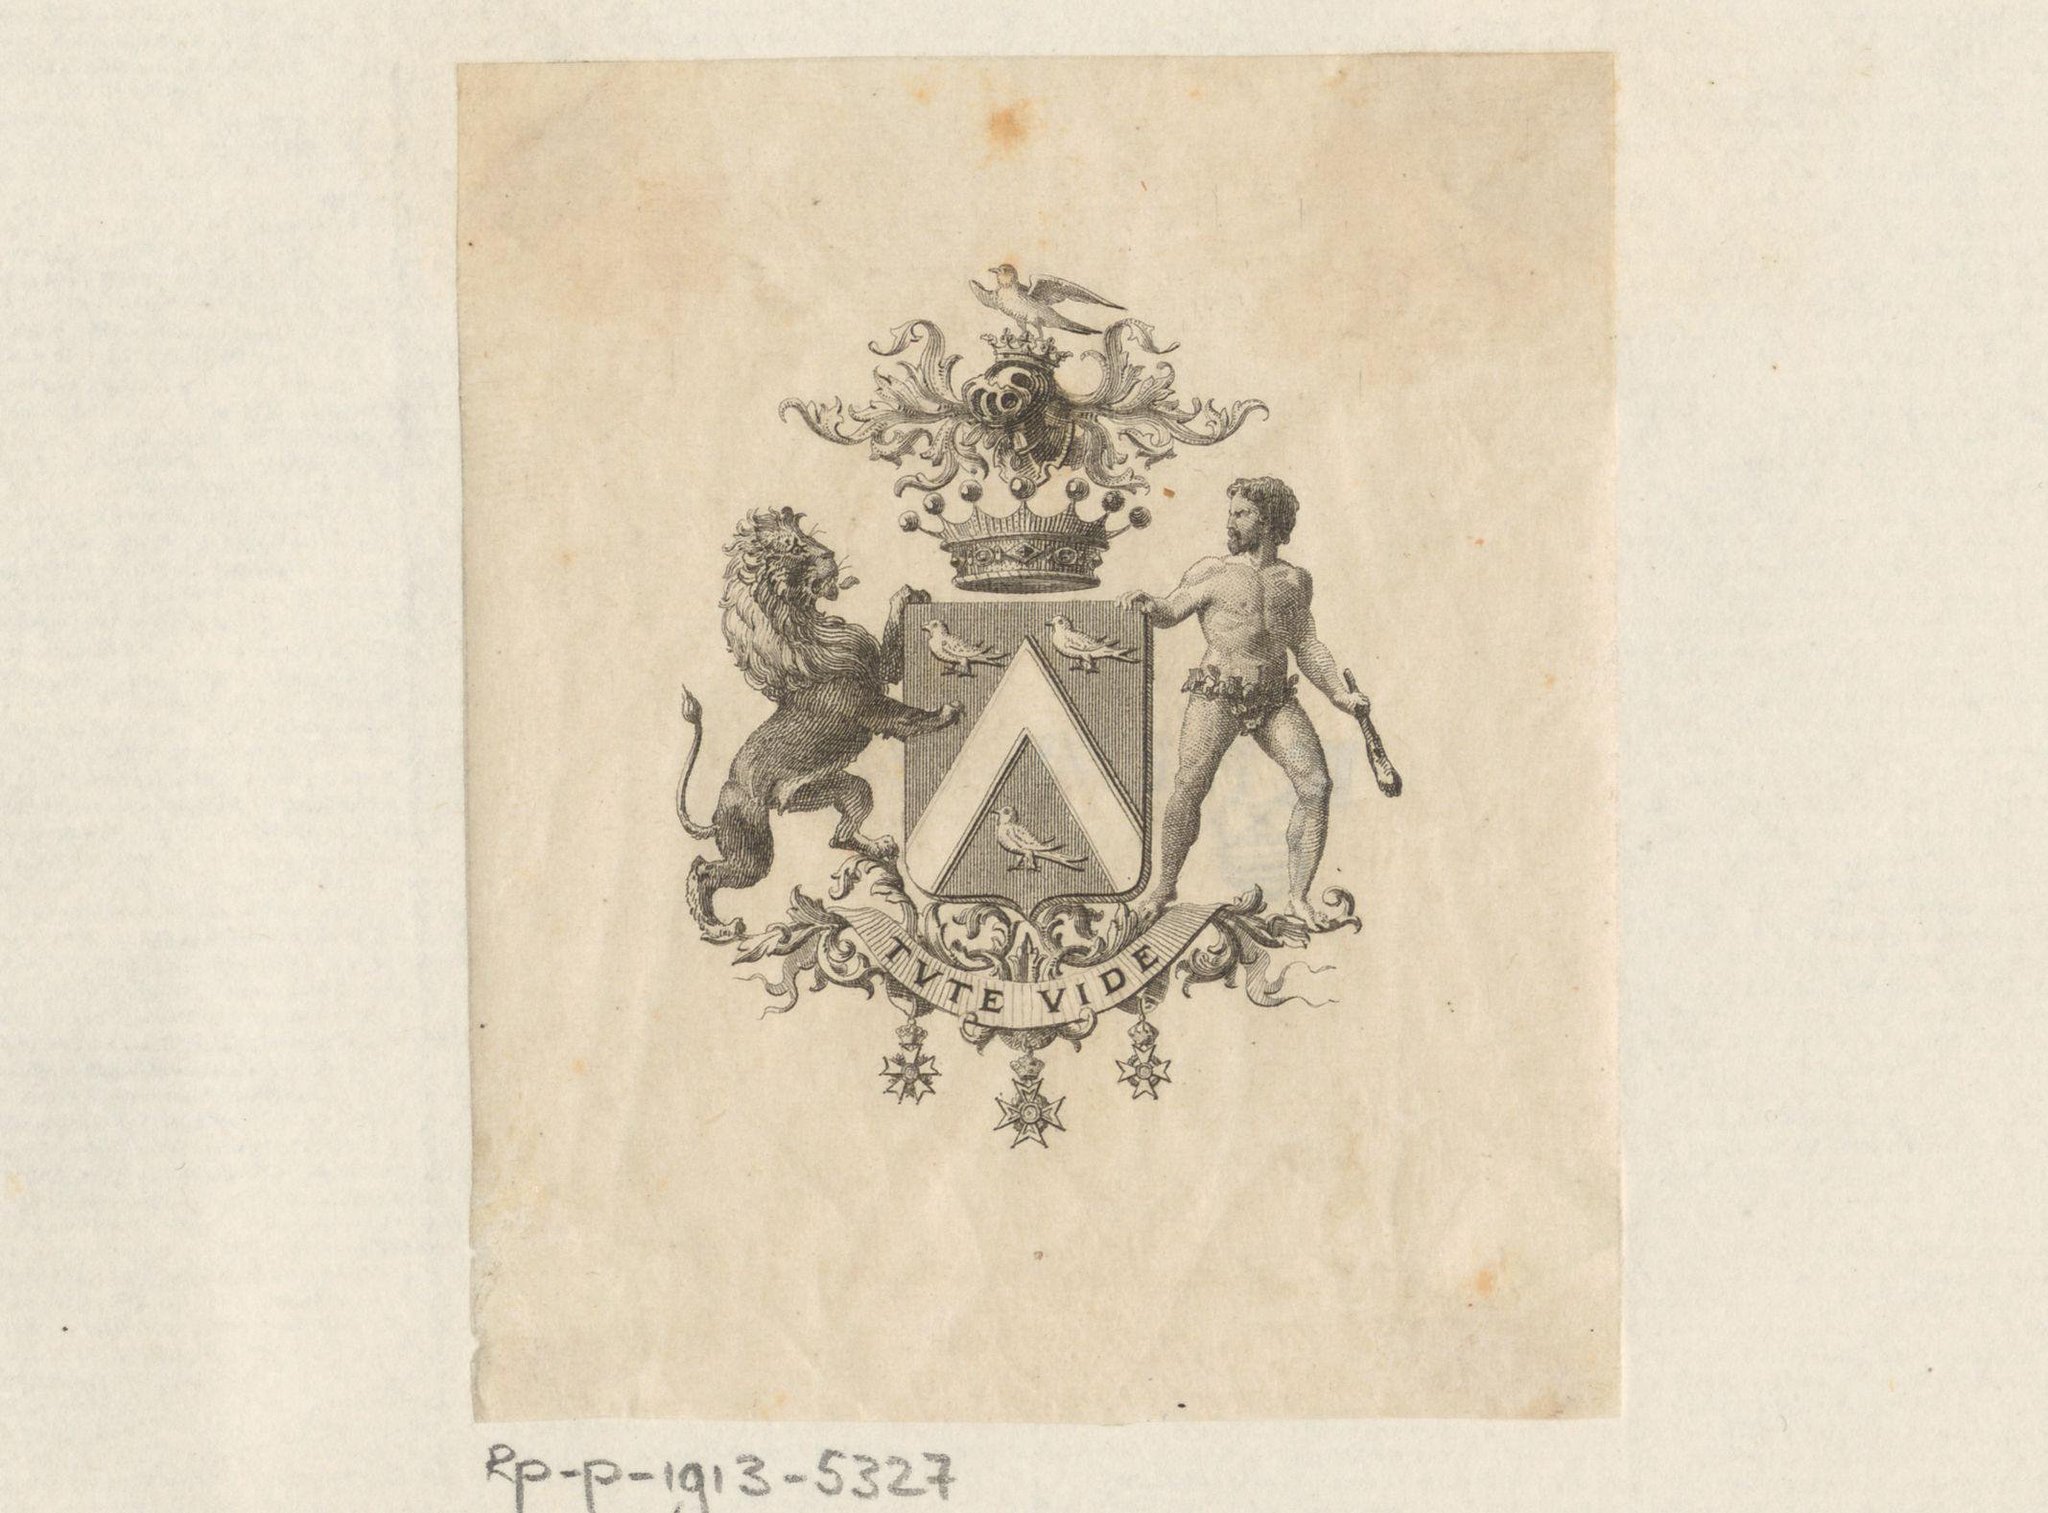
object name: bookplate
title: Ex libris van onbekend, mogelijk De witte de Leverghem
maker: Anonymous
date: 1800-1849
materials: paper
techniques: engraving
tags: armorial bearing, heraldry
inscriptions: collector's mark: Lugt 2233, collector's mark: Lugt 2760